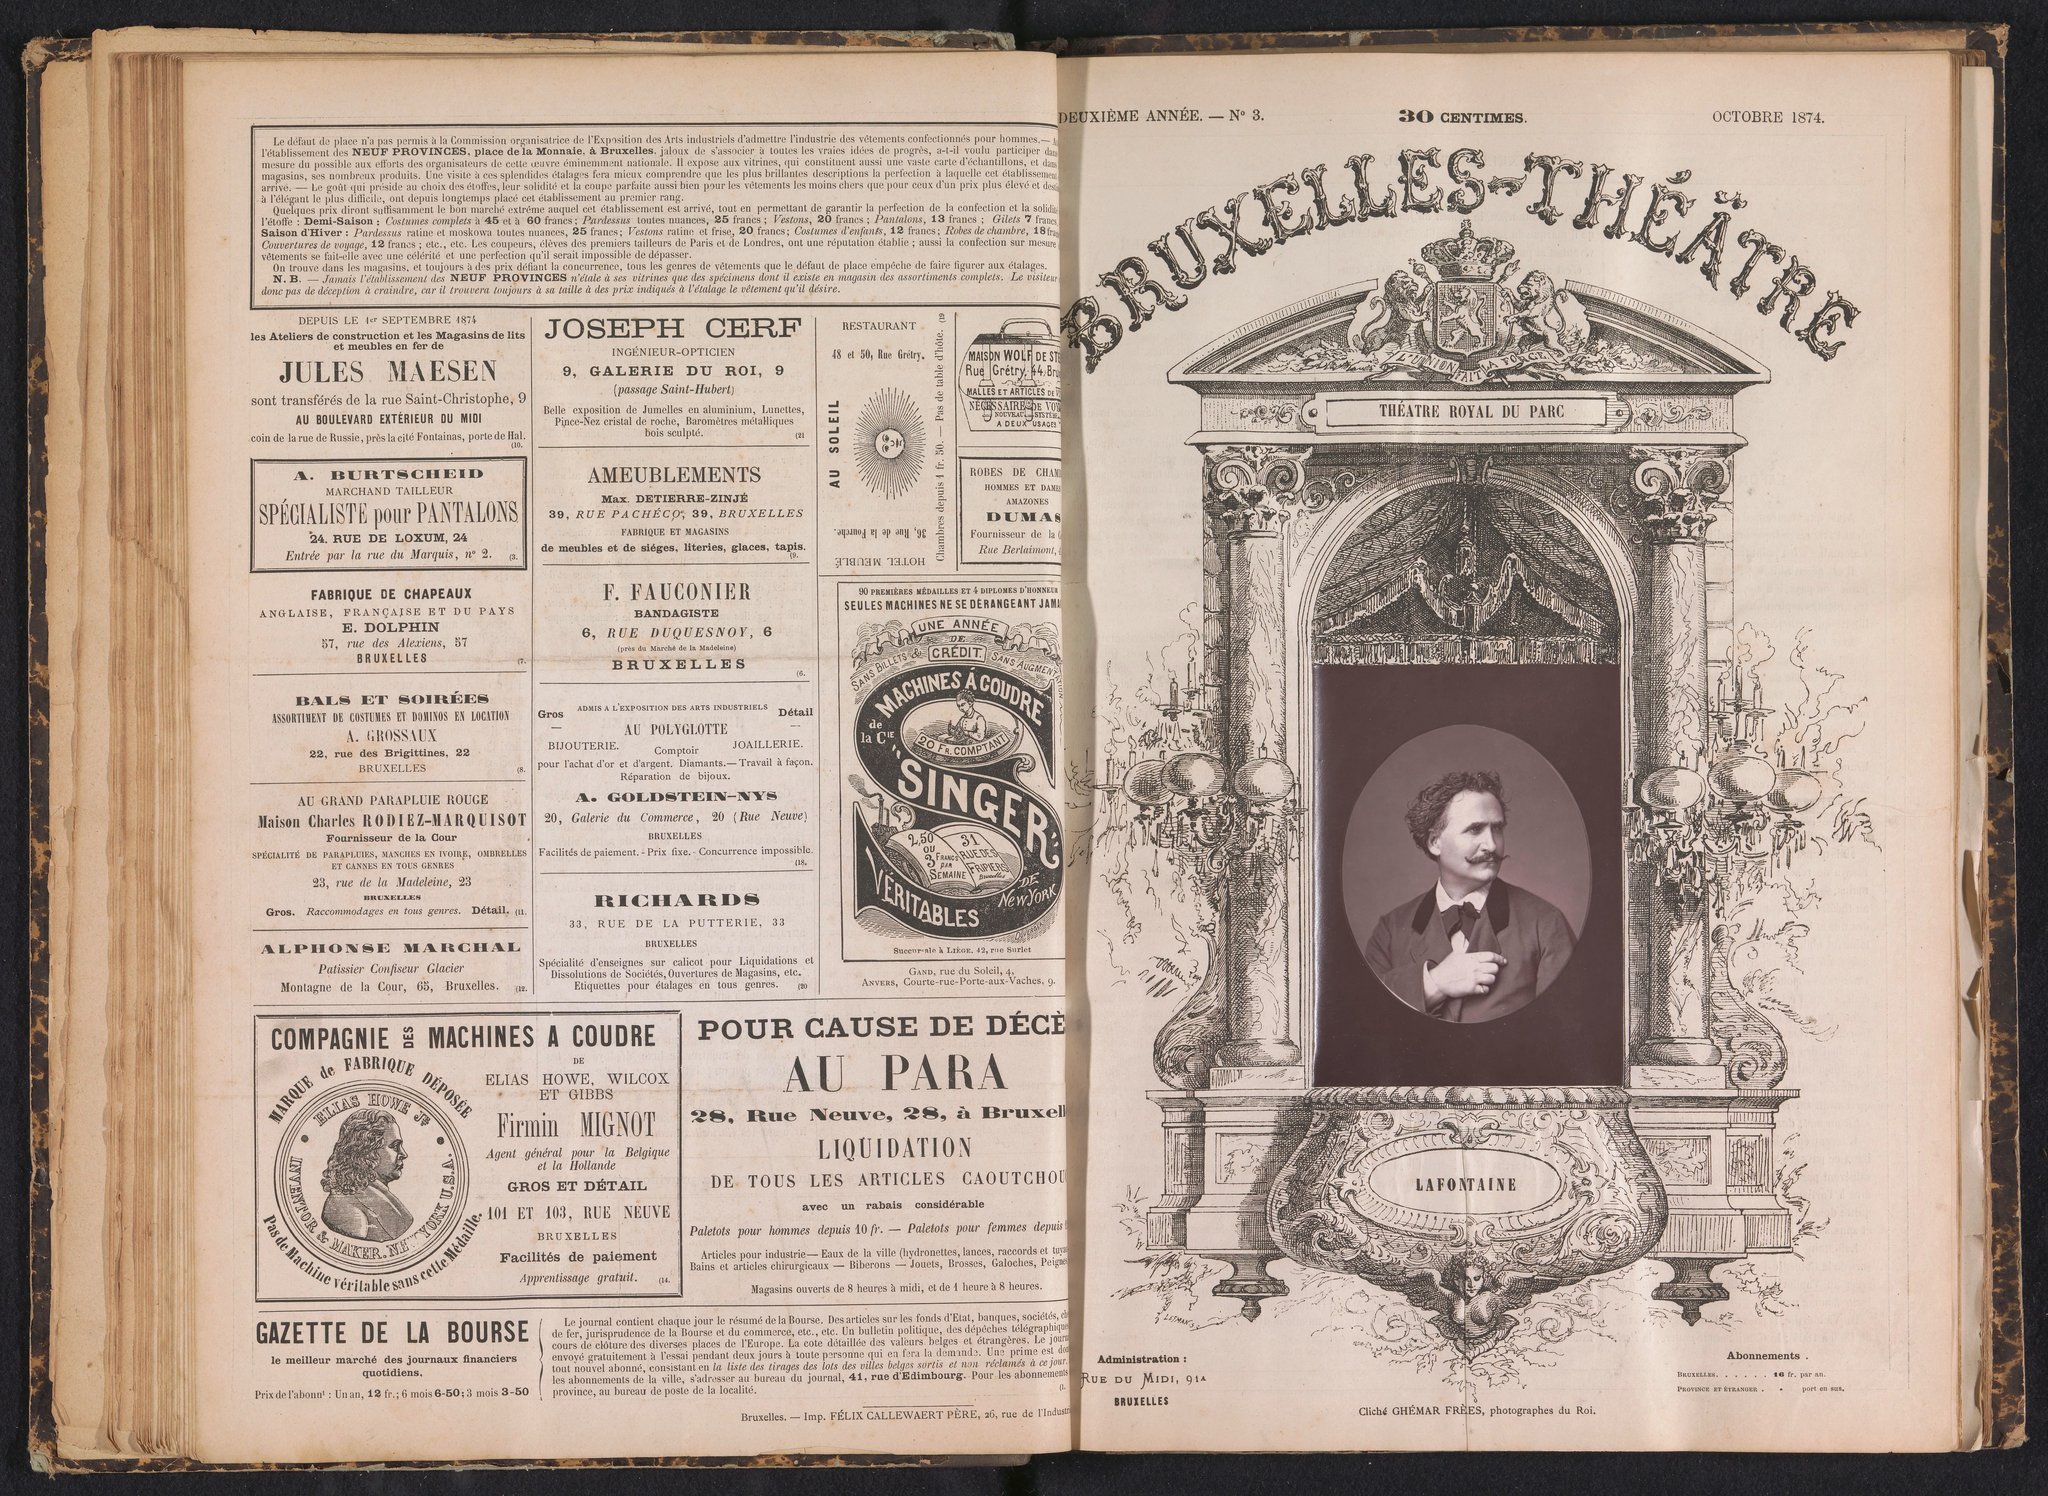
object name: page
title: Portret van Lafontaine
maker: Anonymous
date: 1869-1874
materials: paper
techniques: woodburytype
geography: brussels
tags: portrait of actor, actress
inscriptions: number: ‘No 3.’